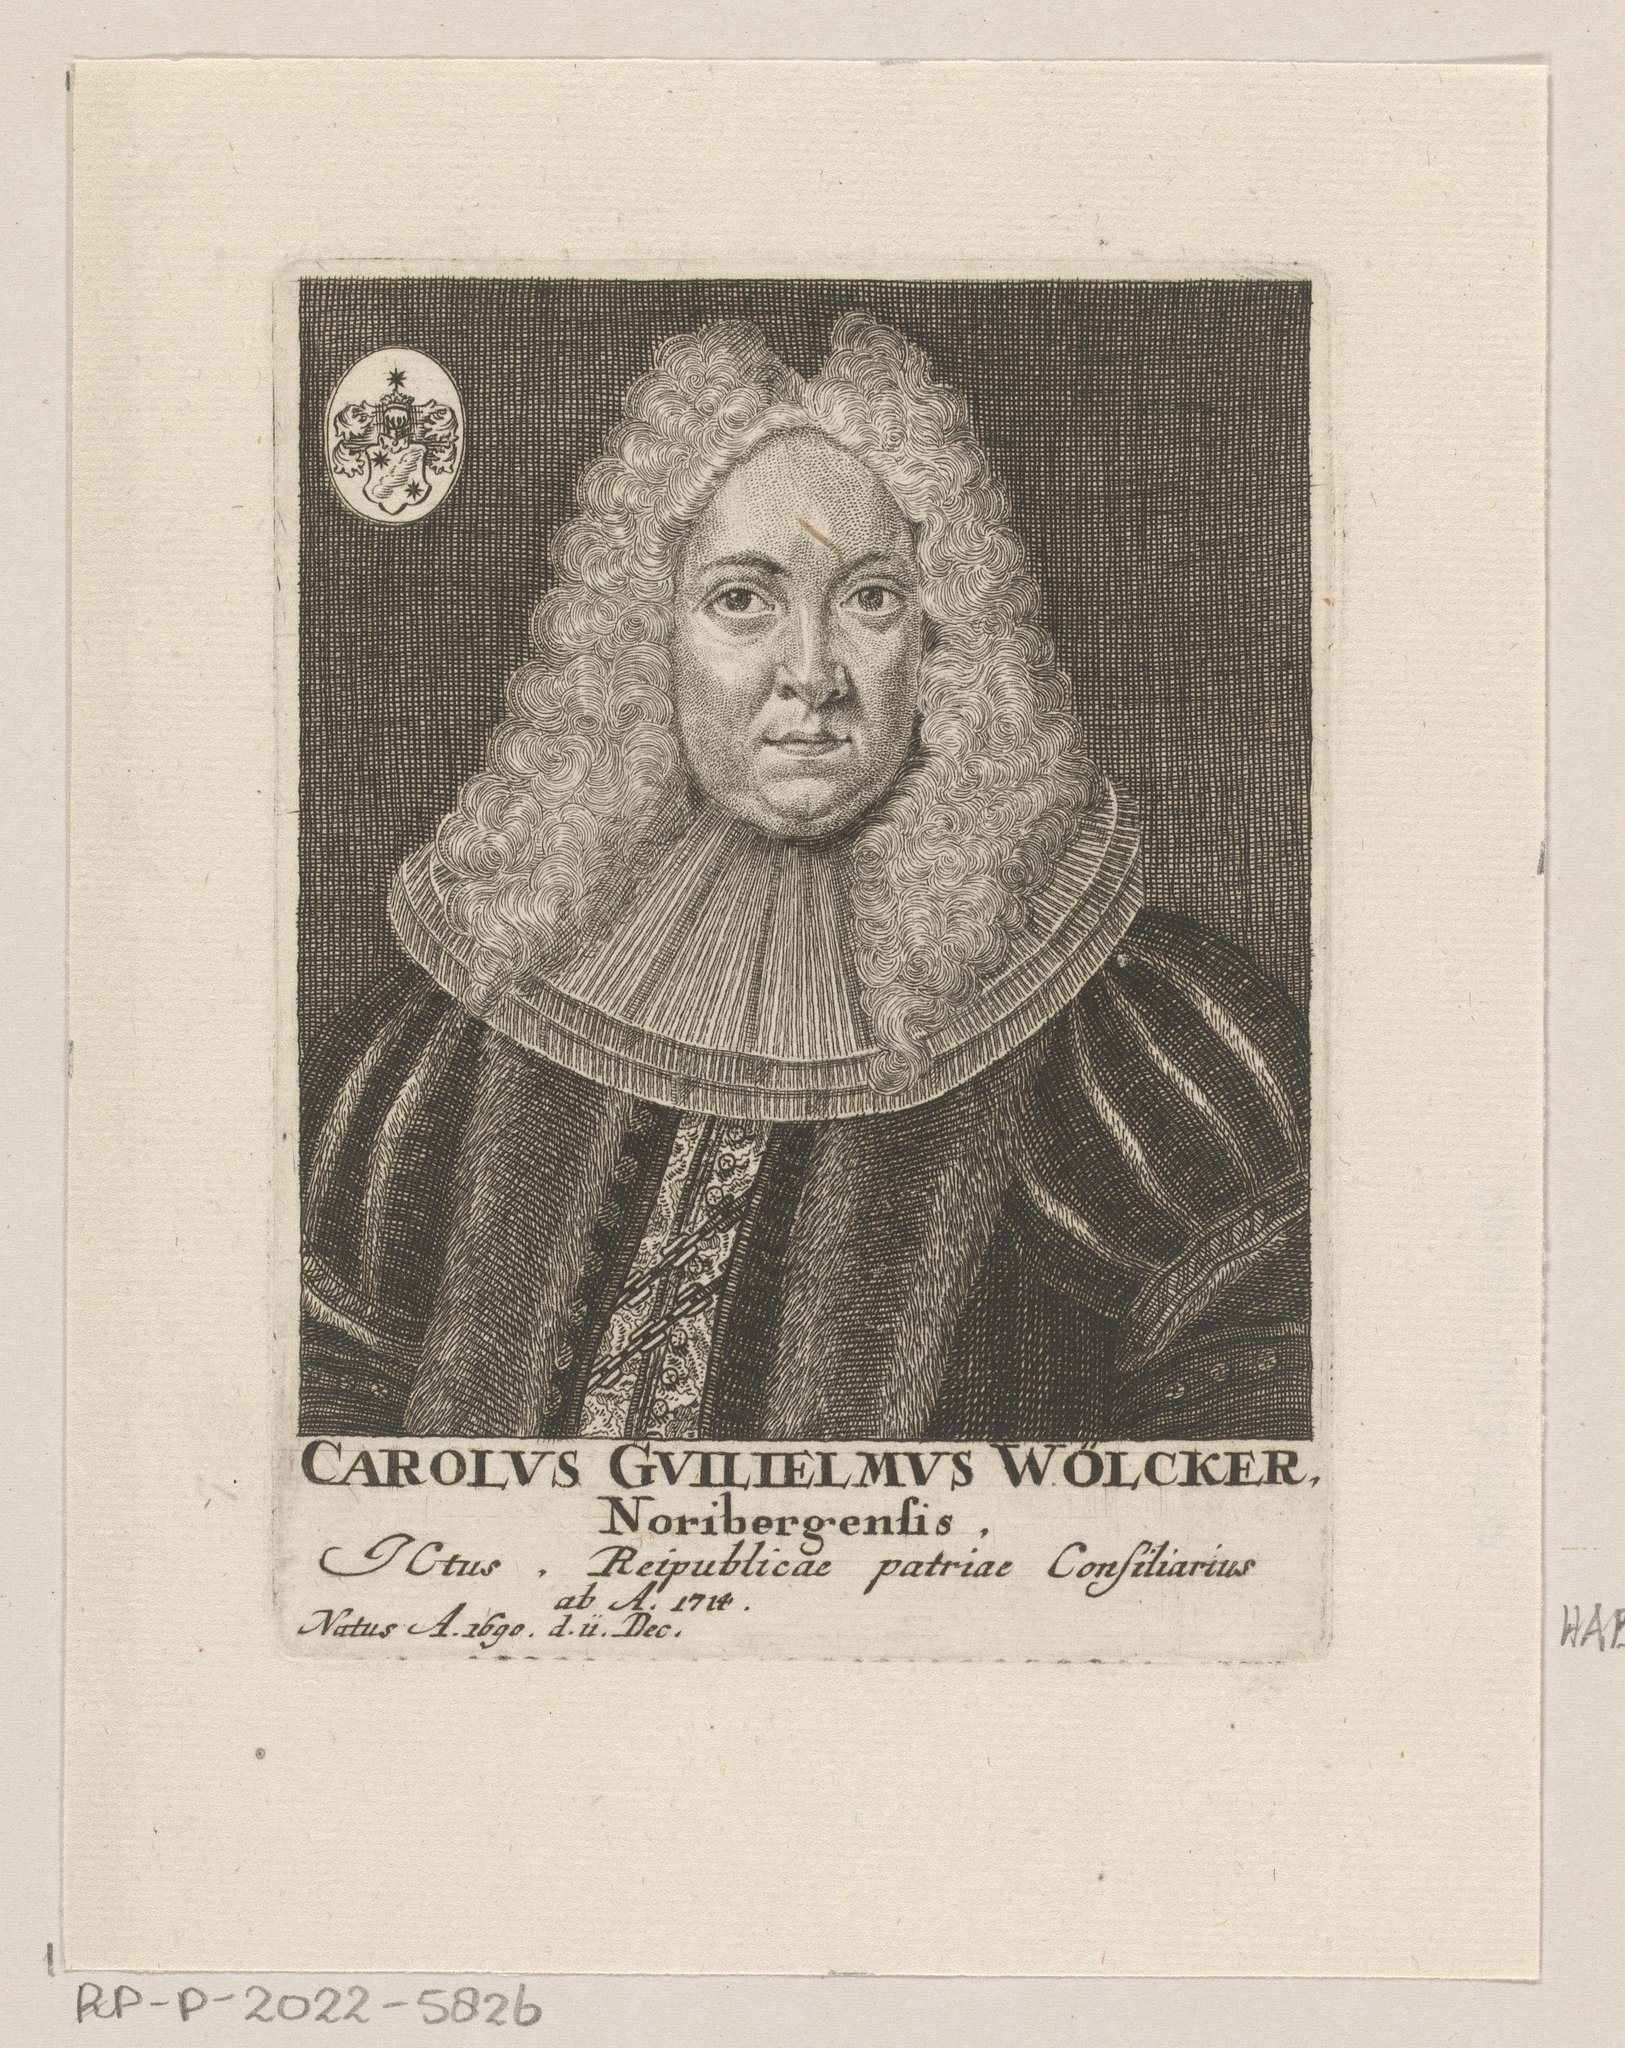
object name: print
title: Portret van Carl Wilhelm Wölckern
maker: Anonymous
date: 1723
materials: paper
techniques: engraving, etching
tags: historical persons, lawyer, attorney at law, armorial bearing, heraldry